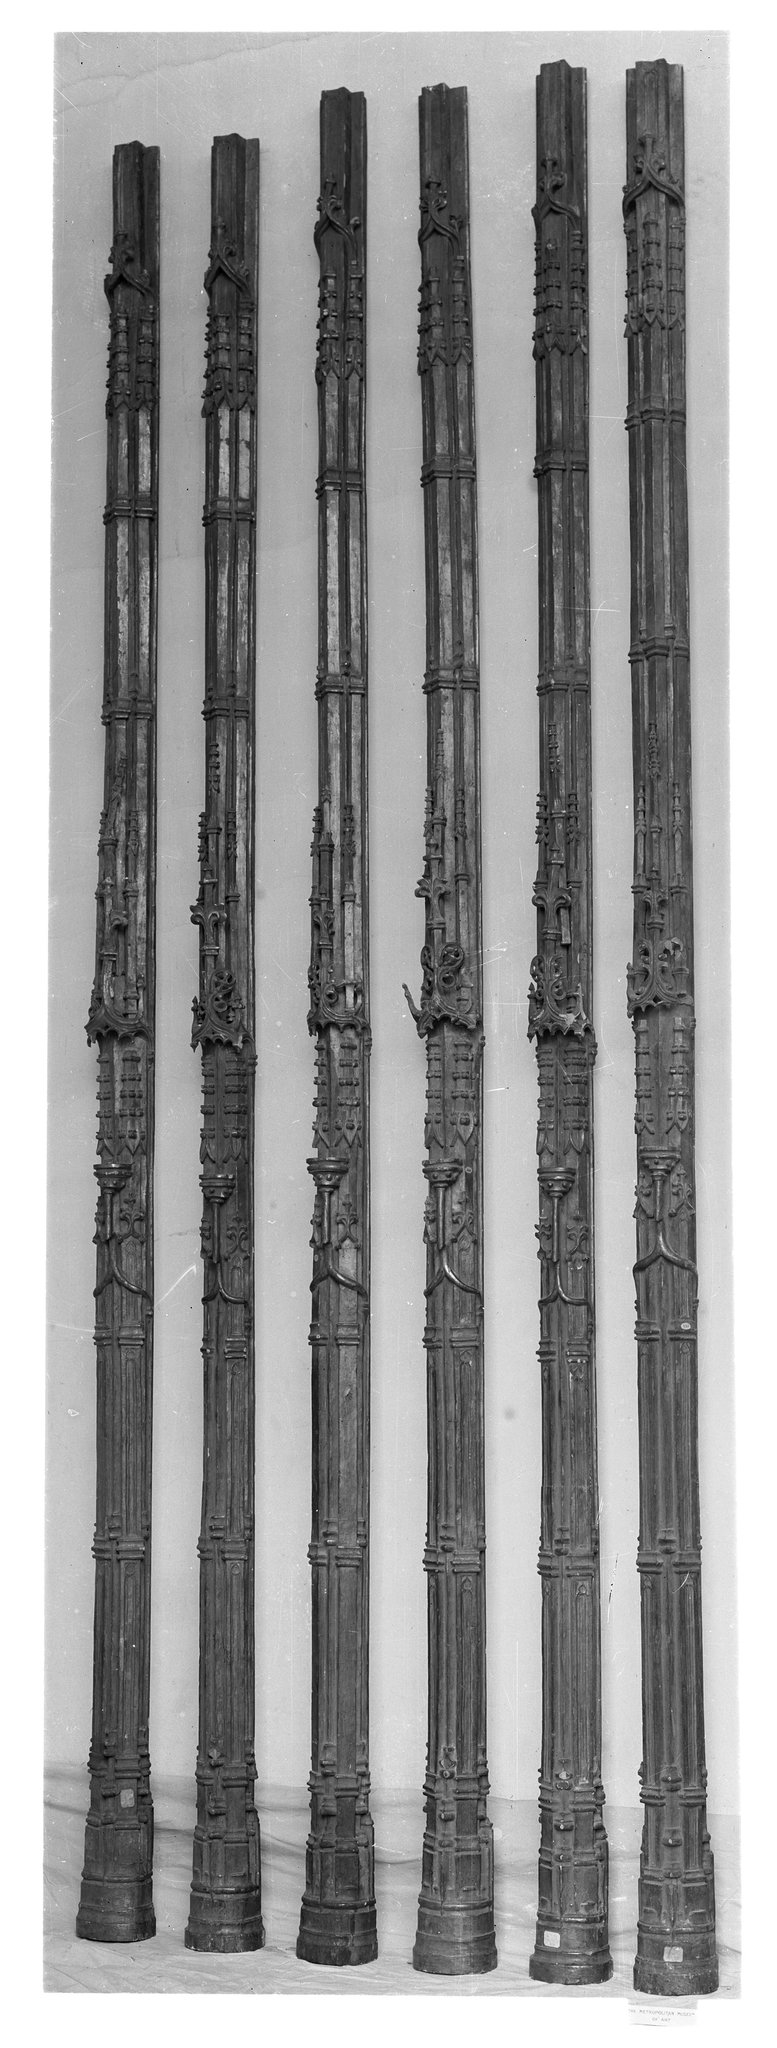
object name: pilaster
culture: french or italian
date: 1501-1600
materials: gold leaf, wood